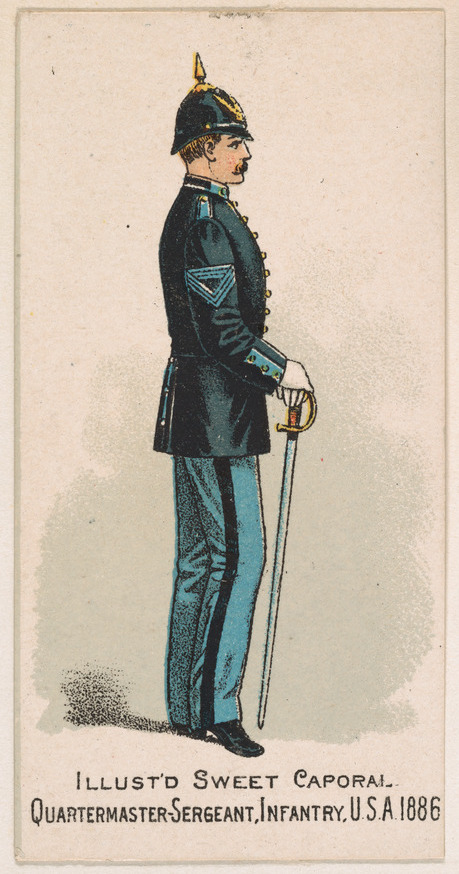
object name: print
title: Quartermaster-Sargeant, Infantry, United States Army, 1886, from the Military Series (N224) issued by Kinney Tobacco Company to promote Sweet Caporal Cigarettes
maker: kinney brothers tobacco company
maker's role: publisher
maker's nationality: american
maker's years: 1869-2011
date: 1888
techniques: color lithograph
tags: army,men,profiles